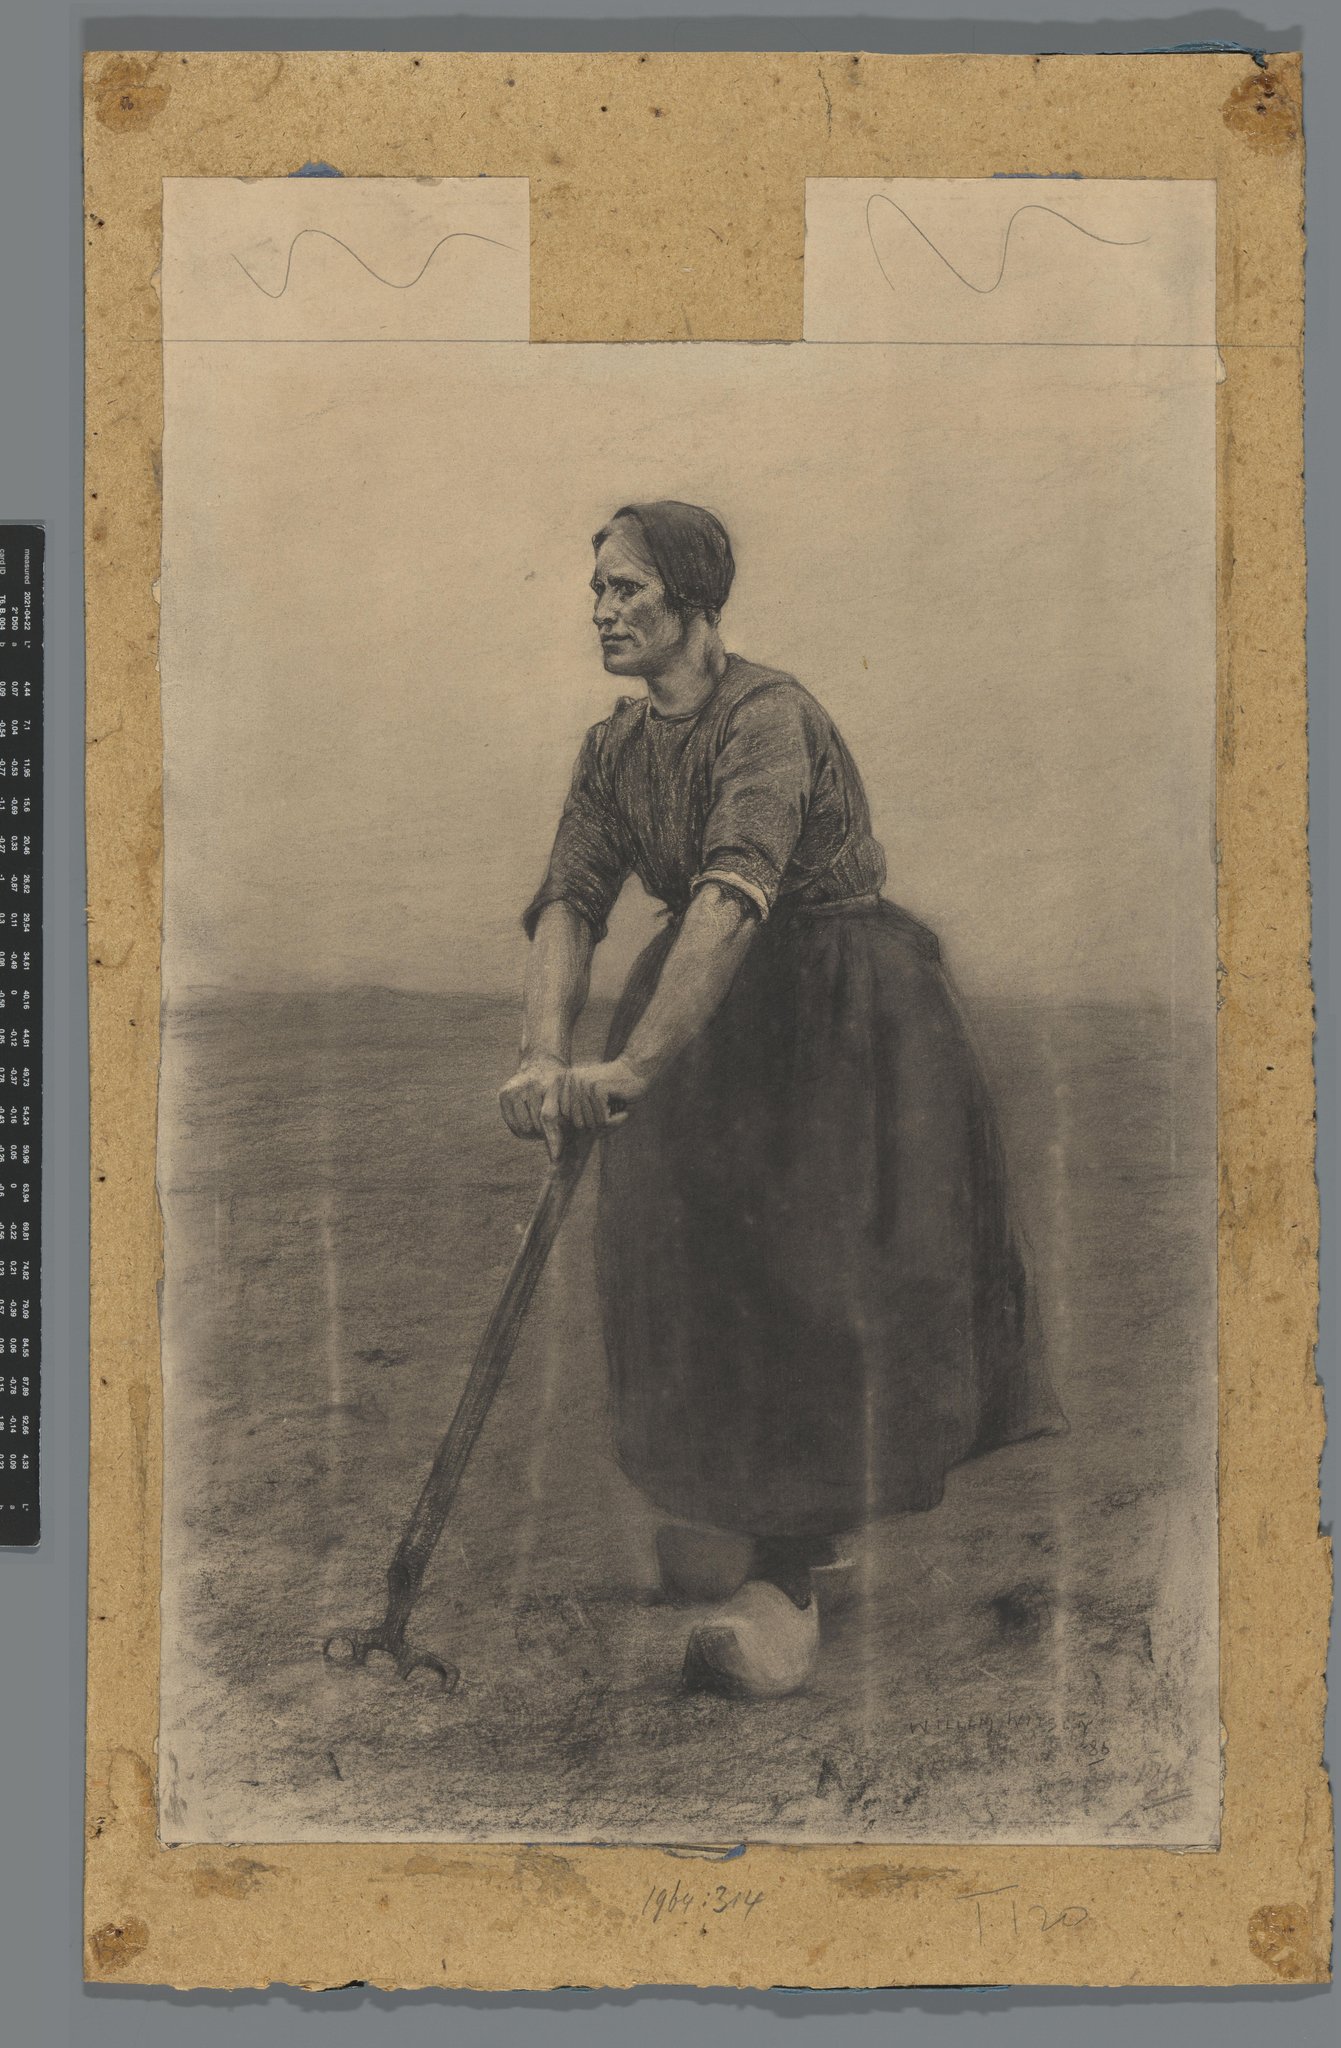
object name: drawing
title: Boerenvrouw, staande op een riek geleund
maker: willem witsen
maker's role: draughtsman, painter, print maker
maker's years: 1860-1923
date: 1885-1886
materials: cardboard, chalk, paper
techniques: scratching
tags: farmers - aa - female farmer, farmer's wife, anonymous historical person portrayed alone - bb - woman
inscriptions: date: ‘86’